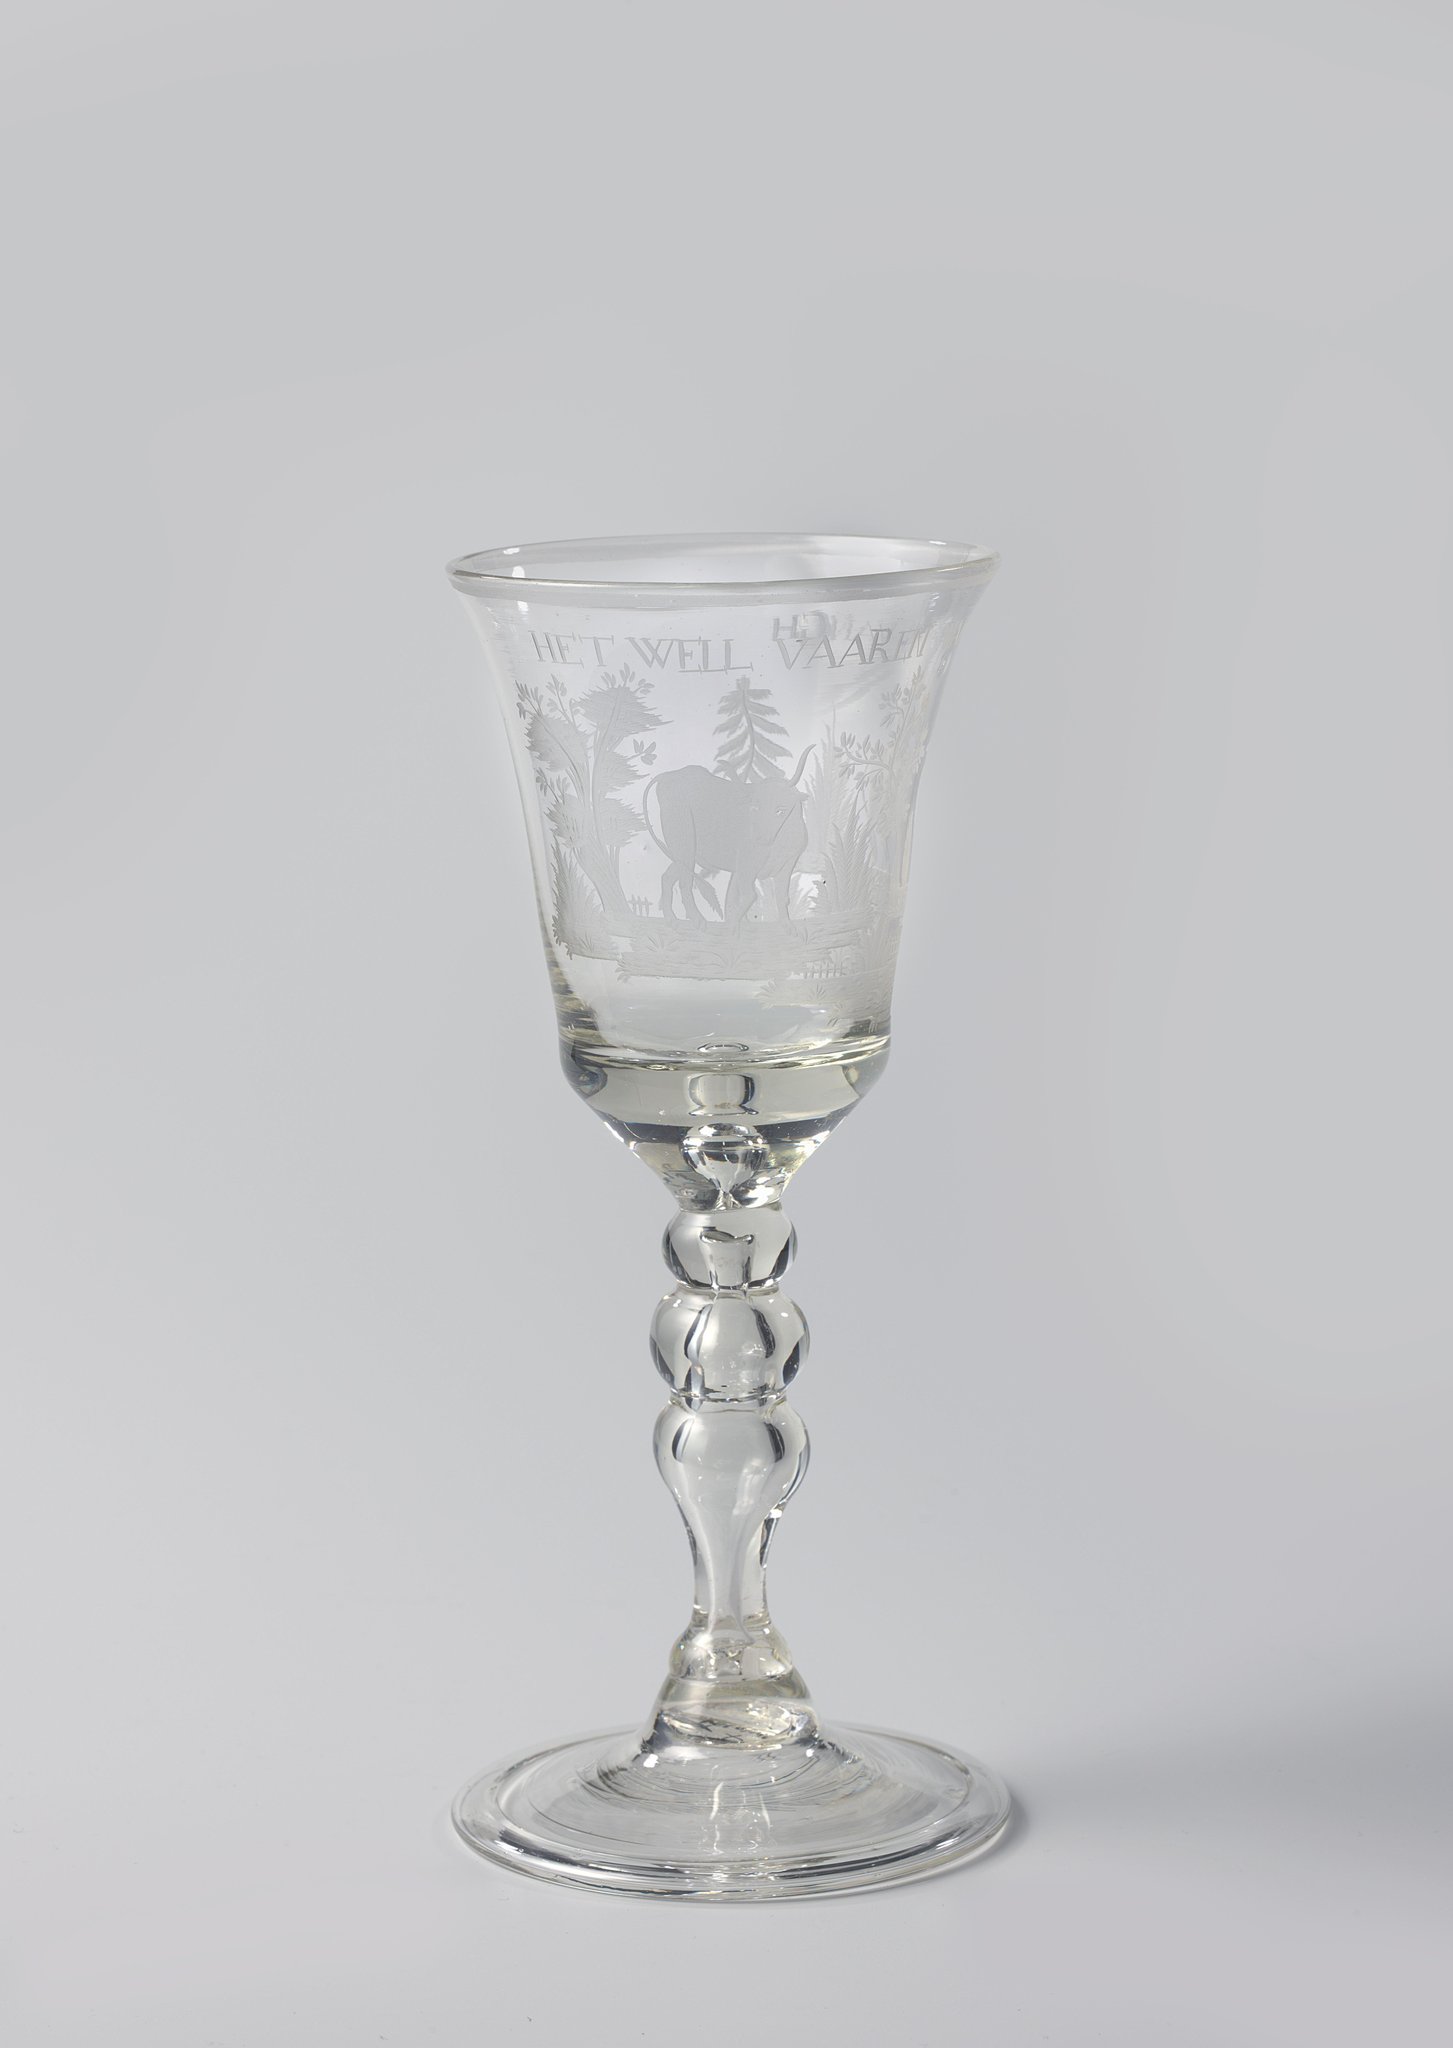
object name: goblet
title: Bokaal met twee koeien en het opschrift: HET WELL VAAREN VAN DE ZEEVANGH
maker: Anonymous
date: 1725-1750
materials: glass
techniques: glassblowing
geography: germany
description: Platte voet met omgeslagen rand. Balusterstam met drie knopen en een langgerekte luchtbel. Klokvormige kelk met afgeronde bodem. Op de kelk twee koeien tussen bomen waarboven: HET WELL VAAREN VAN DE ZEEVANGH. Zeevangh was waarschijnlijk de naam van een boerderij.